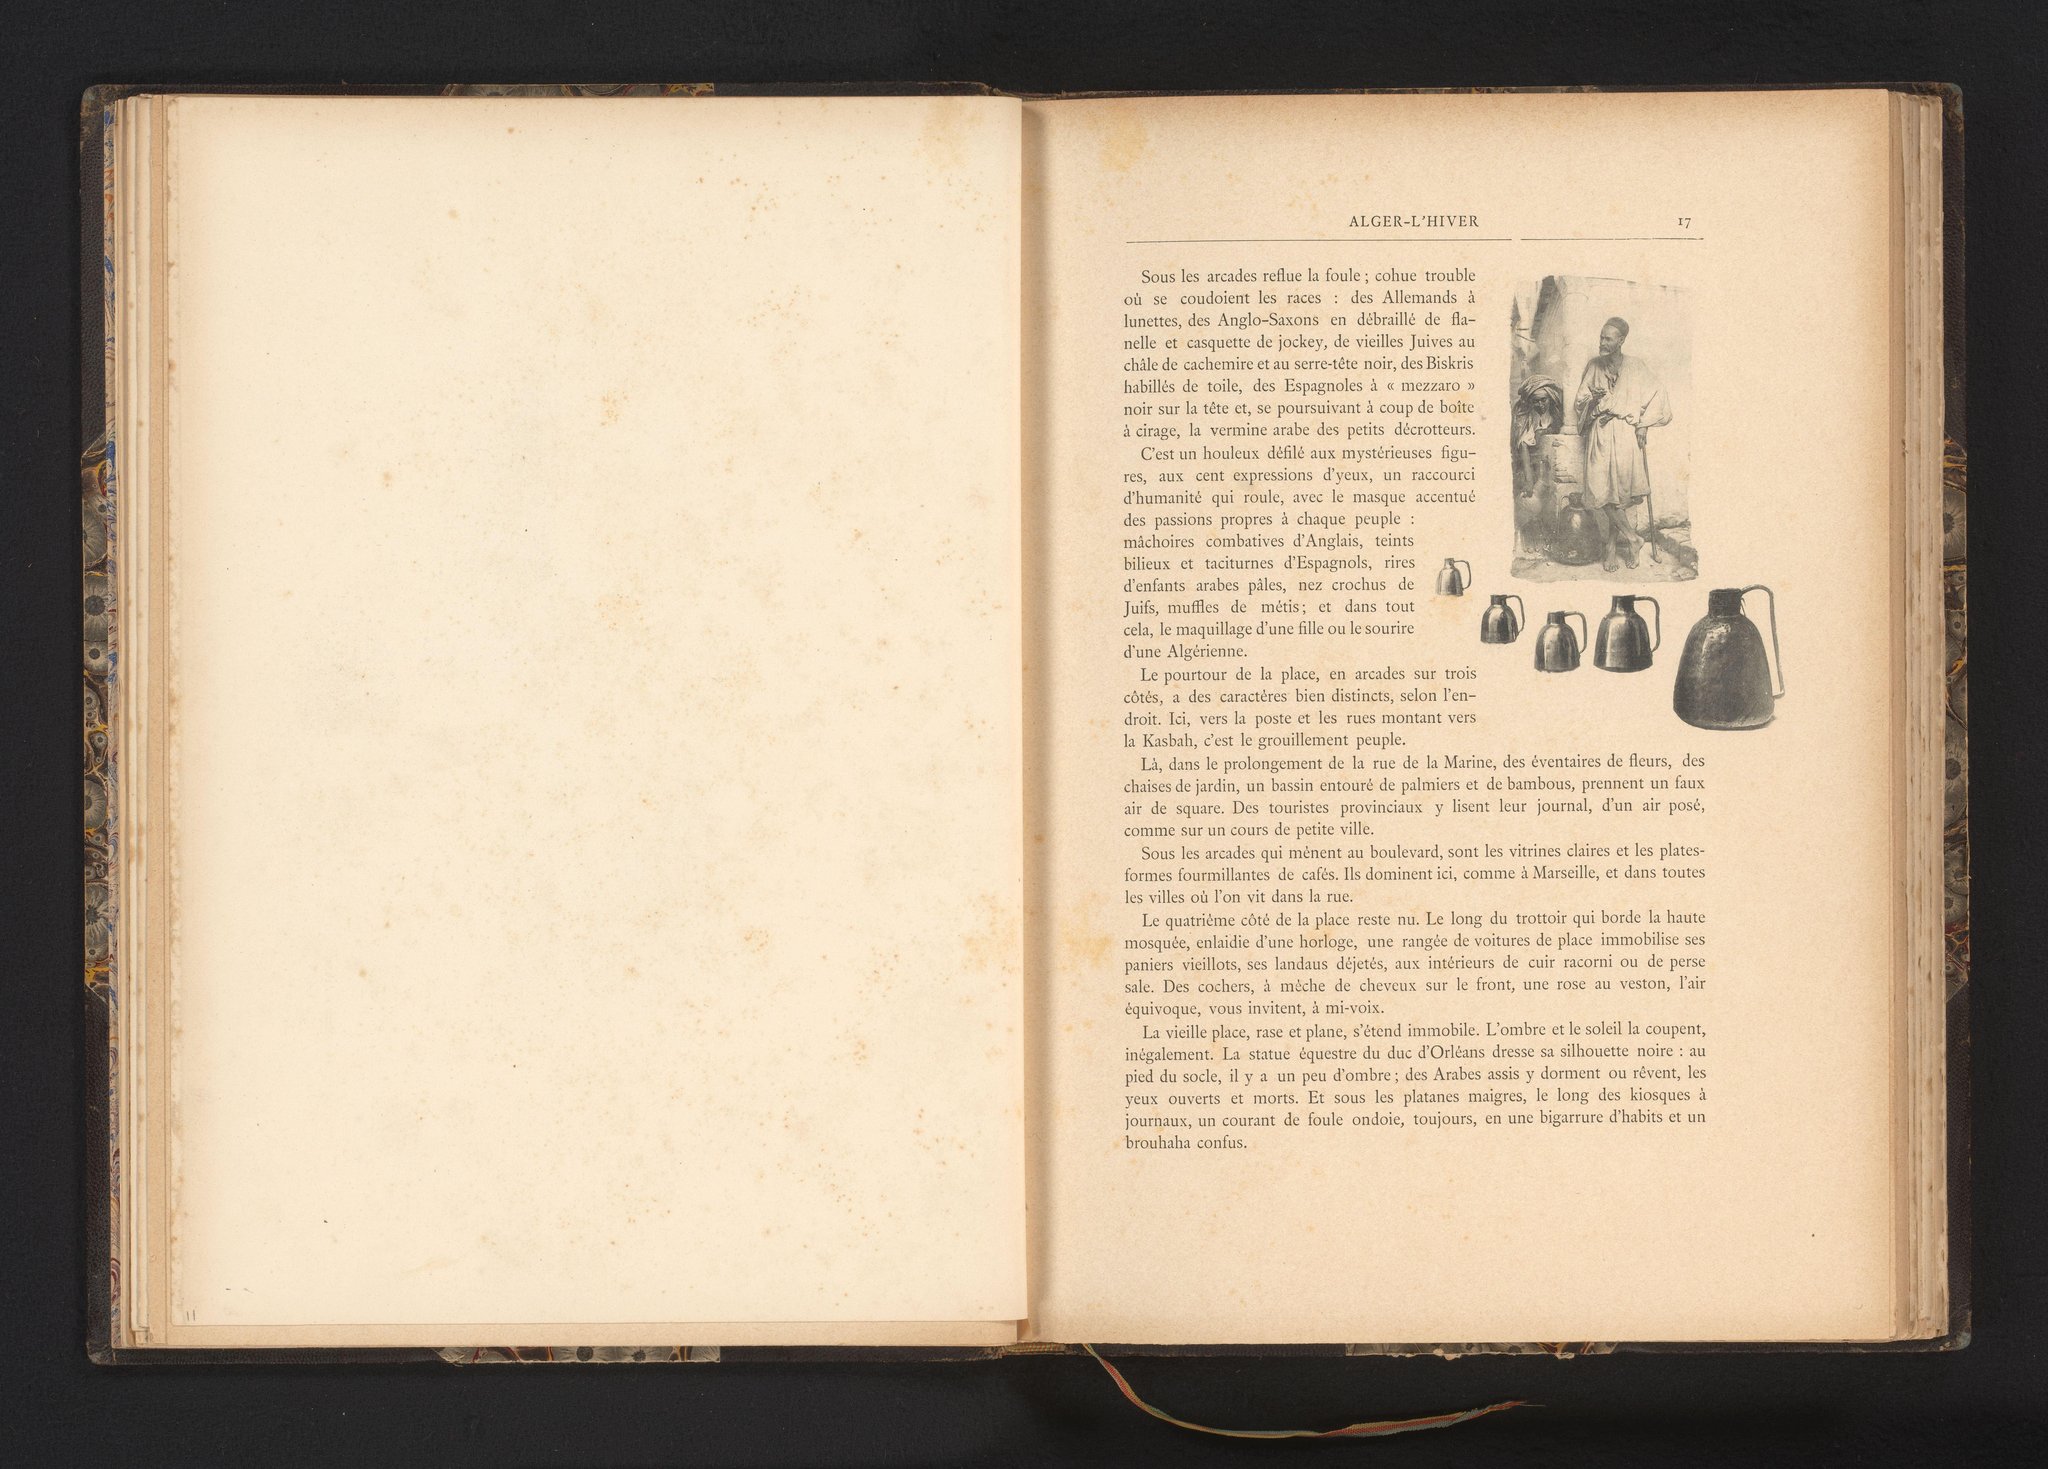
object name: photomechanical print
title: Man en een vrouw bij een waterpomp in Algiers, Algerije, met daaronder vijf waterkannen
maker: jules gervais-courtellemont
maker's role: fotograaf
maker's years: 1863-1931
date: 1888-1893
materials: paper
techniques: photograph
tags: containers, utilitarian, public pump or water fountain